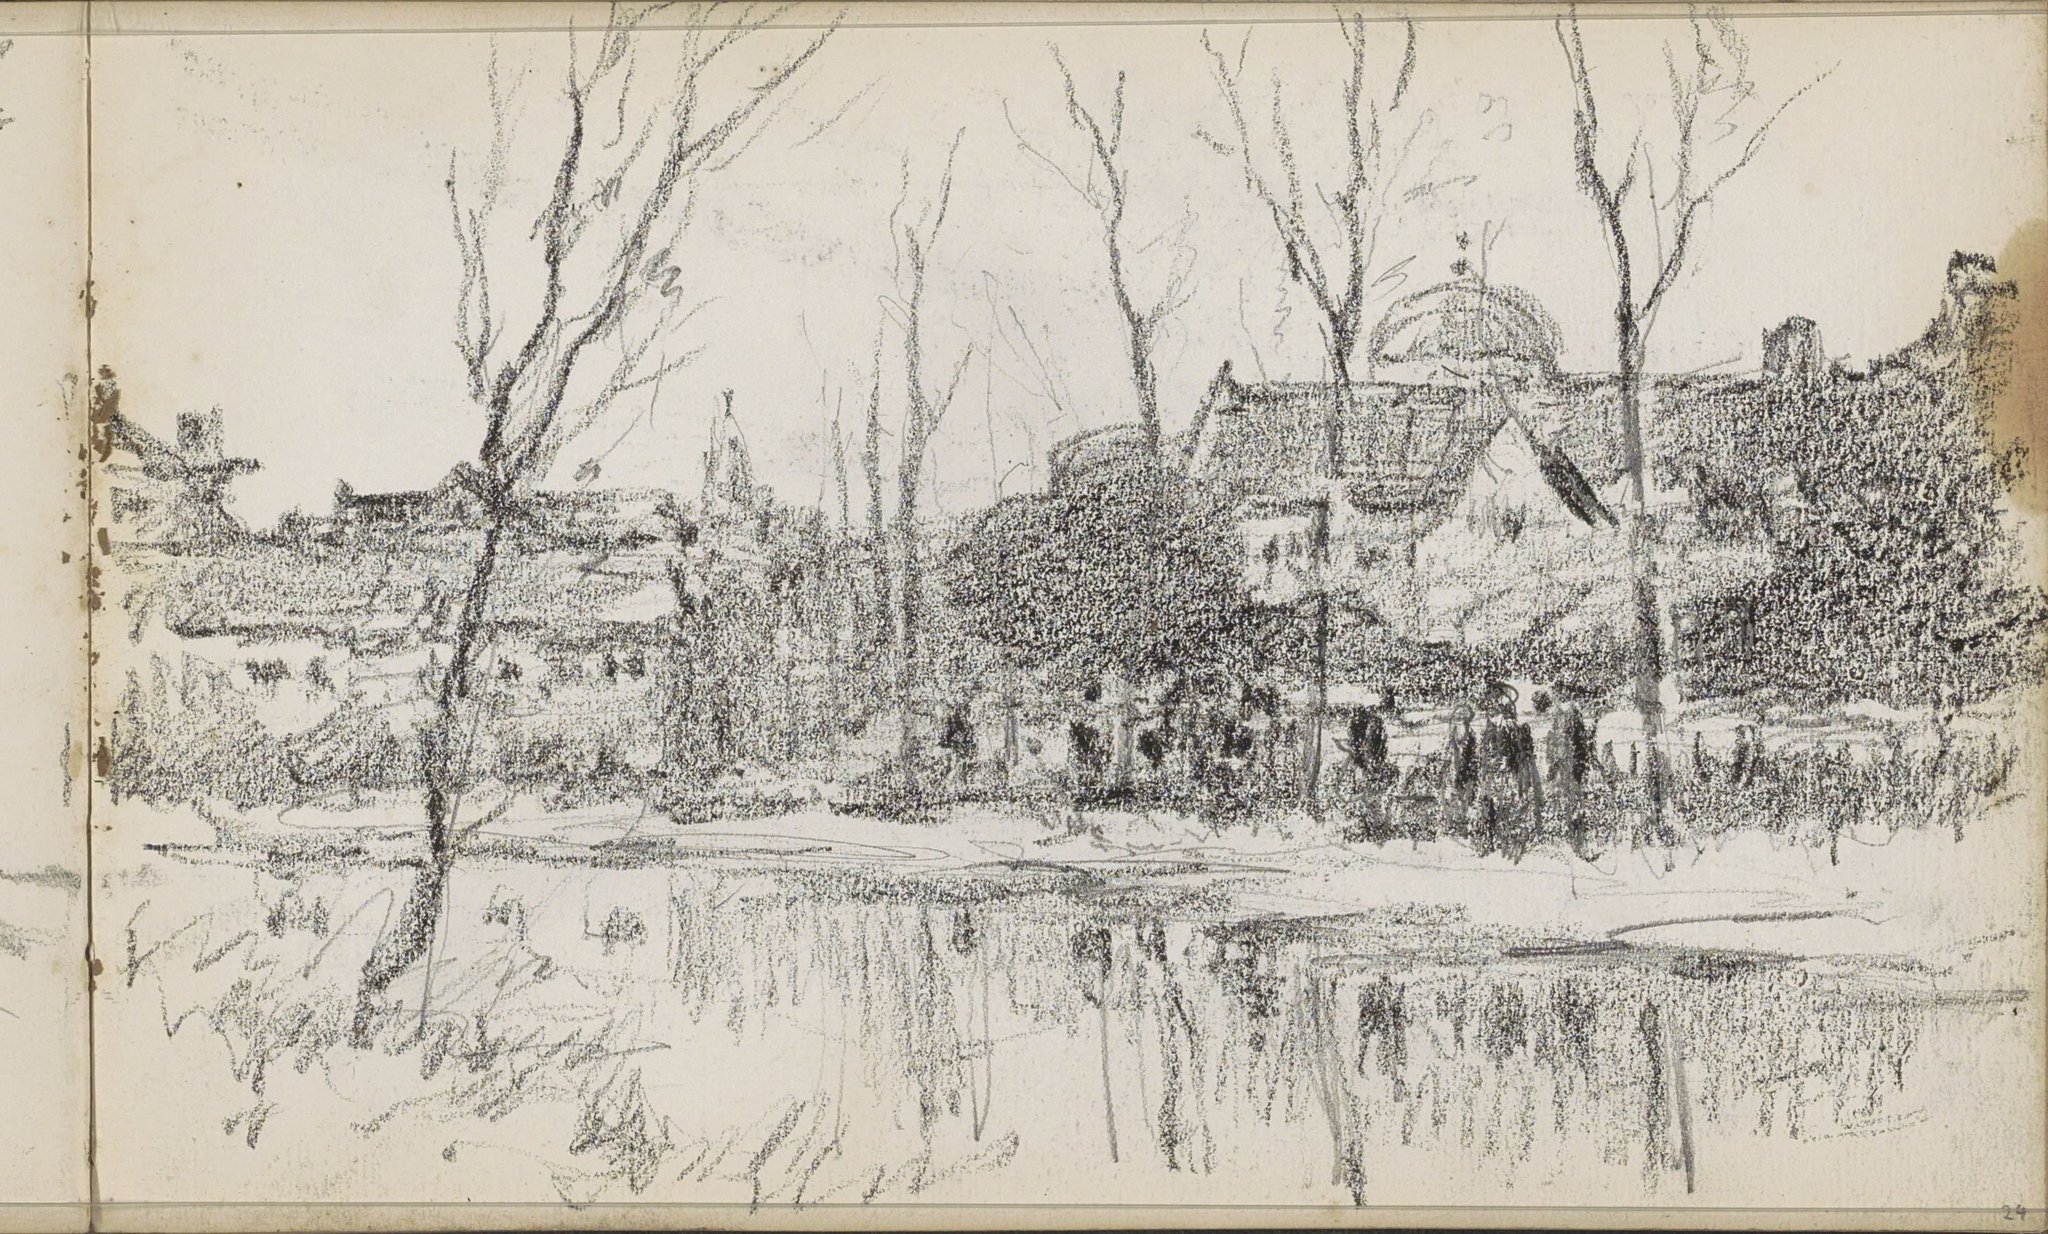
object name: sketchbook leaf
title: Huizen en bomen langs een waterkant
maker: willem cornelis rip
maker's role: draughtsman, painter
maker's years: 1856-1922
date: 1876-1877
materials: chalk, paper, pencil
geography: the hague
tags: landscapes with waters, waterscapes, seascapes (in the temperate zone), the usual house or row of houses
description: Blad 24 recto uit een schetsboek met 41 bladen.